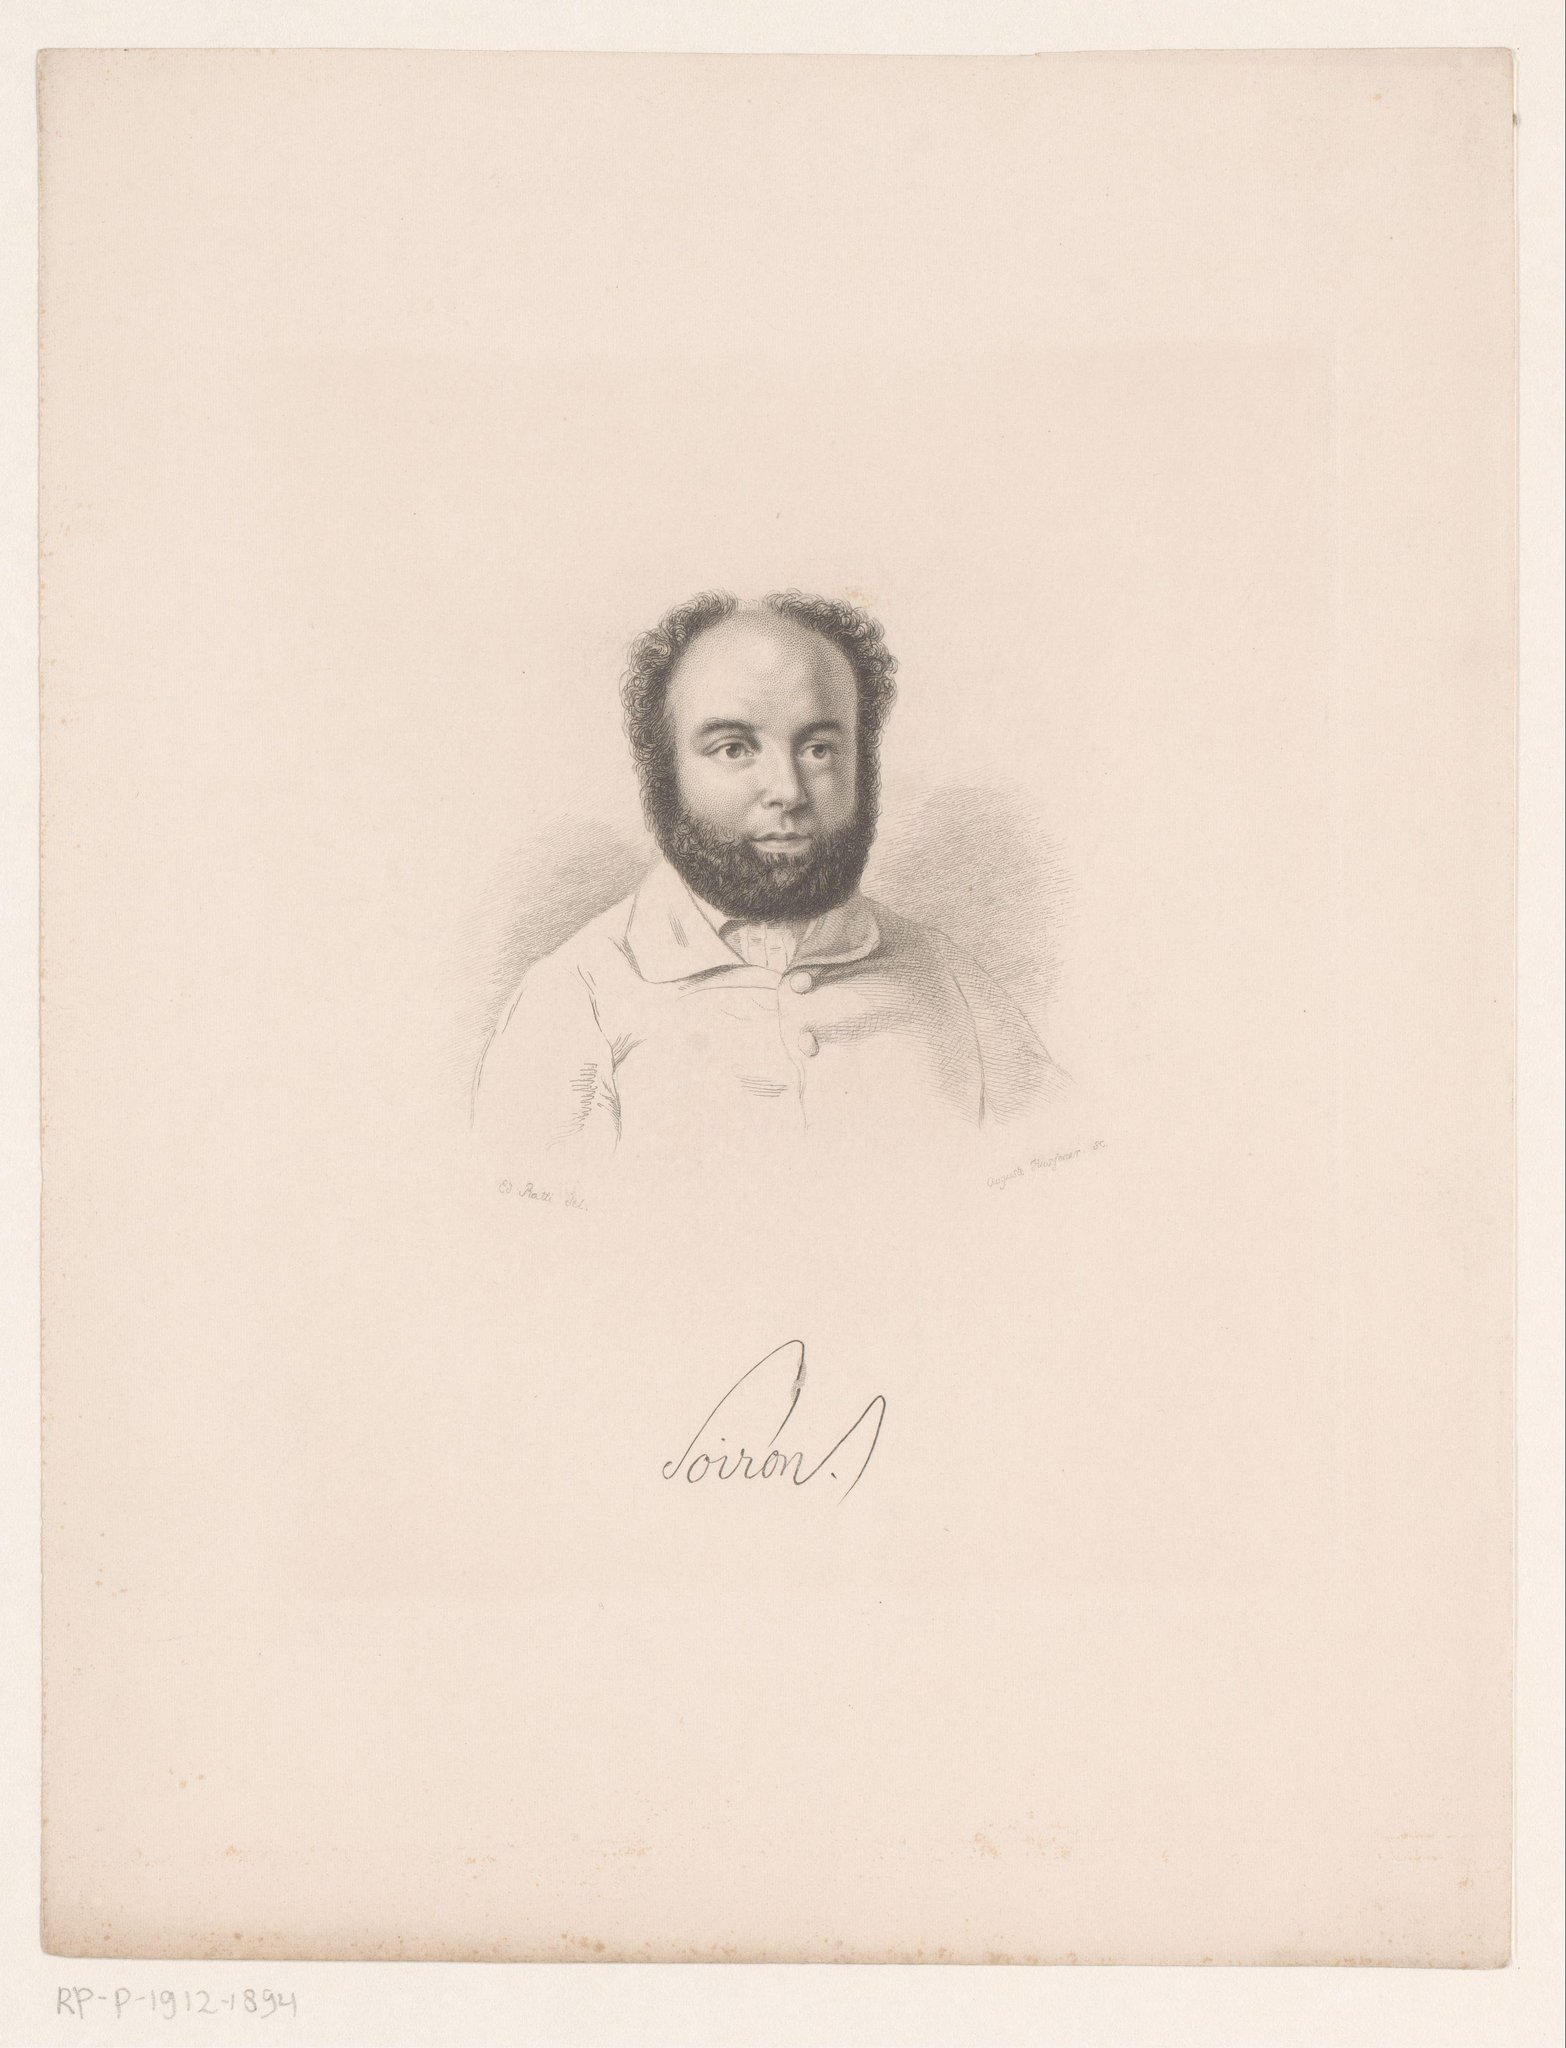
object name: print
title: Portret van Alexander von Soiron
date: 1826-1877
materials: paper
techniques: engraving, etching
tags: historical persons, lawyer, attorney at law, politician, e.g. party leader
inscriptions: collector's mark: Lugt 2228